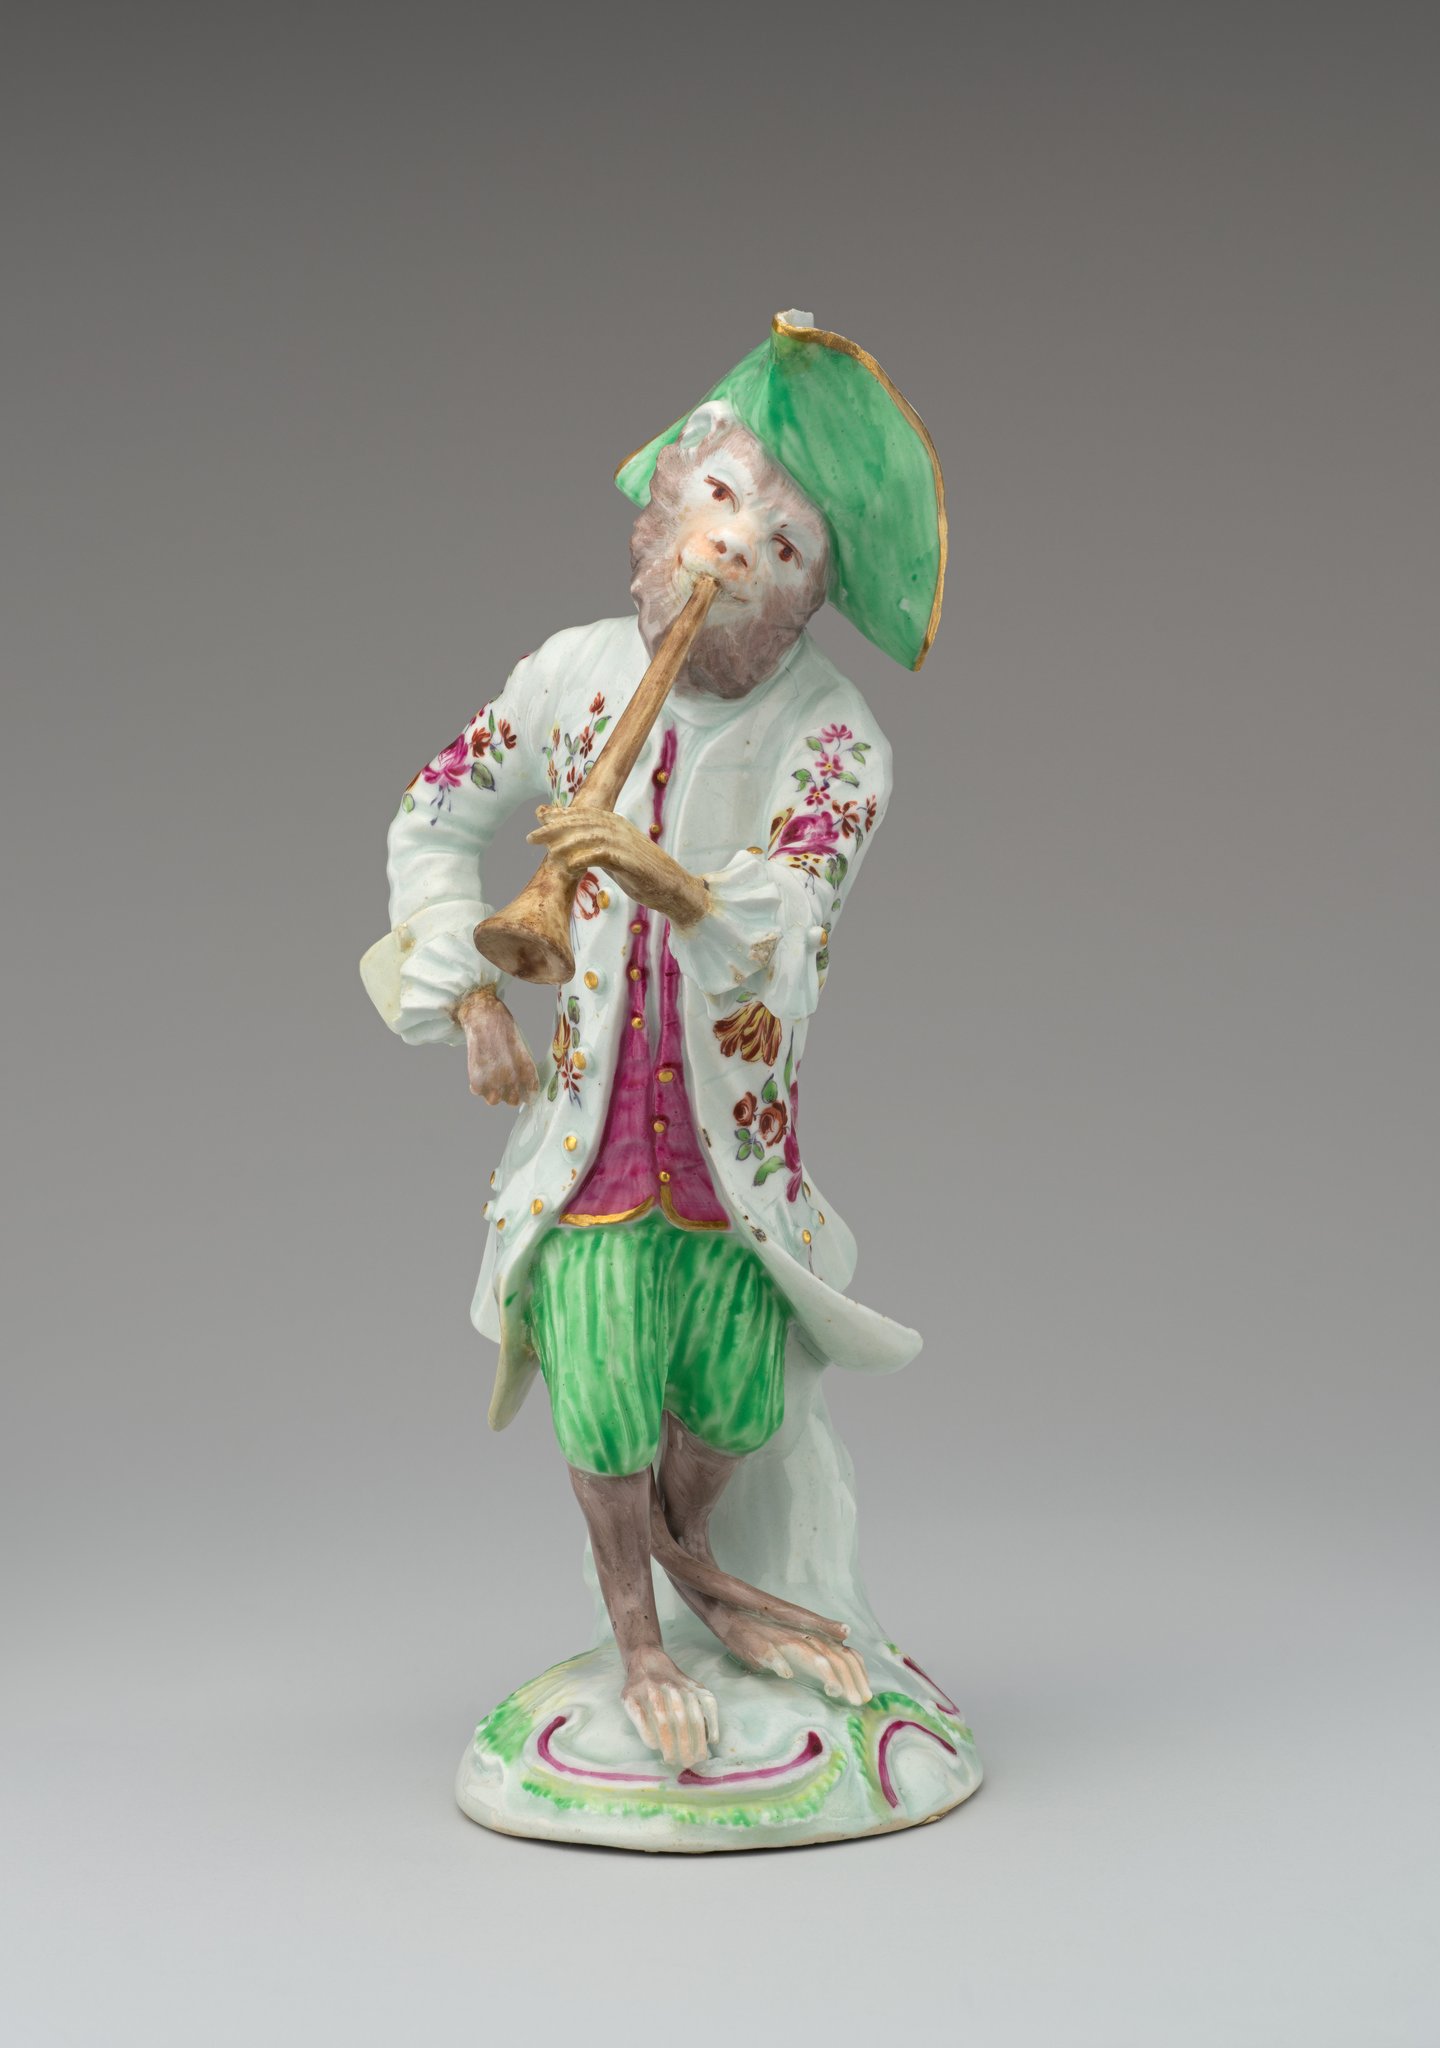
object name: figure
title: Monkey musician (part of a set)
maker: derby porcelain manufactory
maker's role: factory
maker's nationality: british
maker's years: 1751-1785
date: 1760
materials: soft paste porcelain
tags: monkeys,musicians